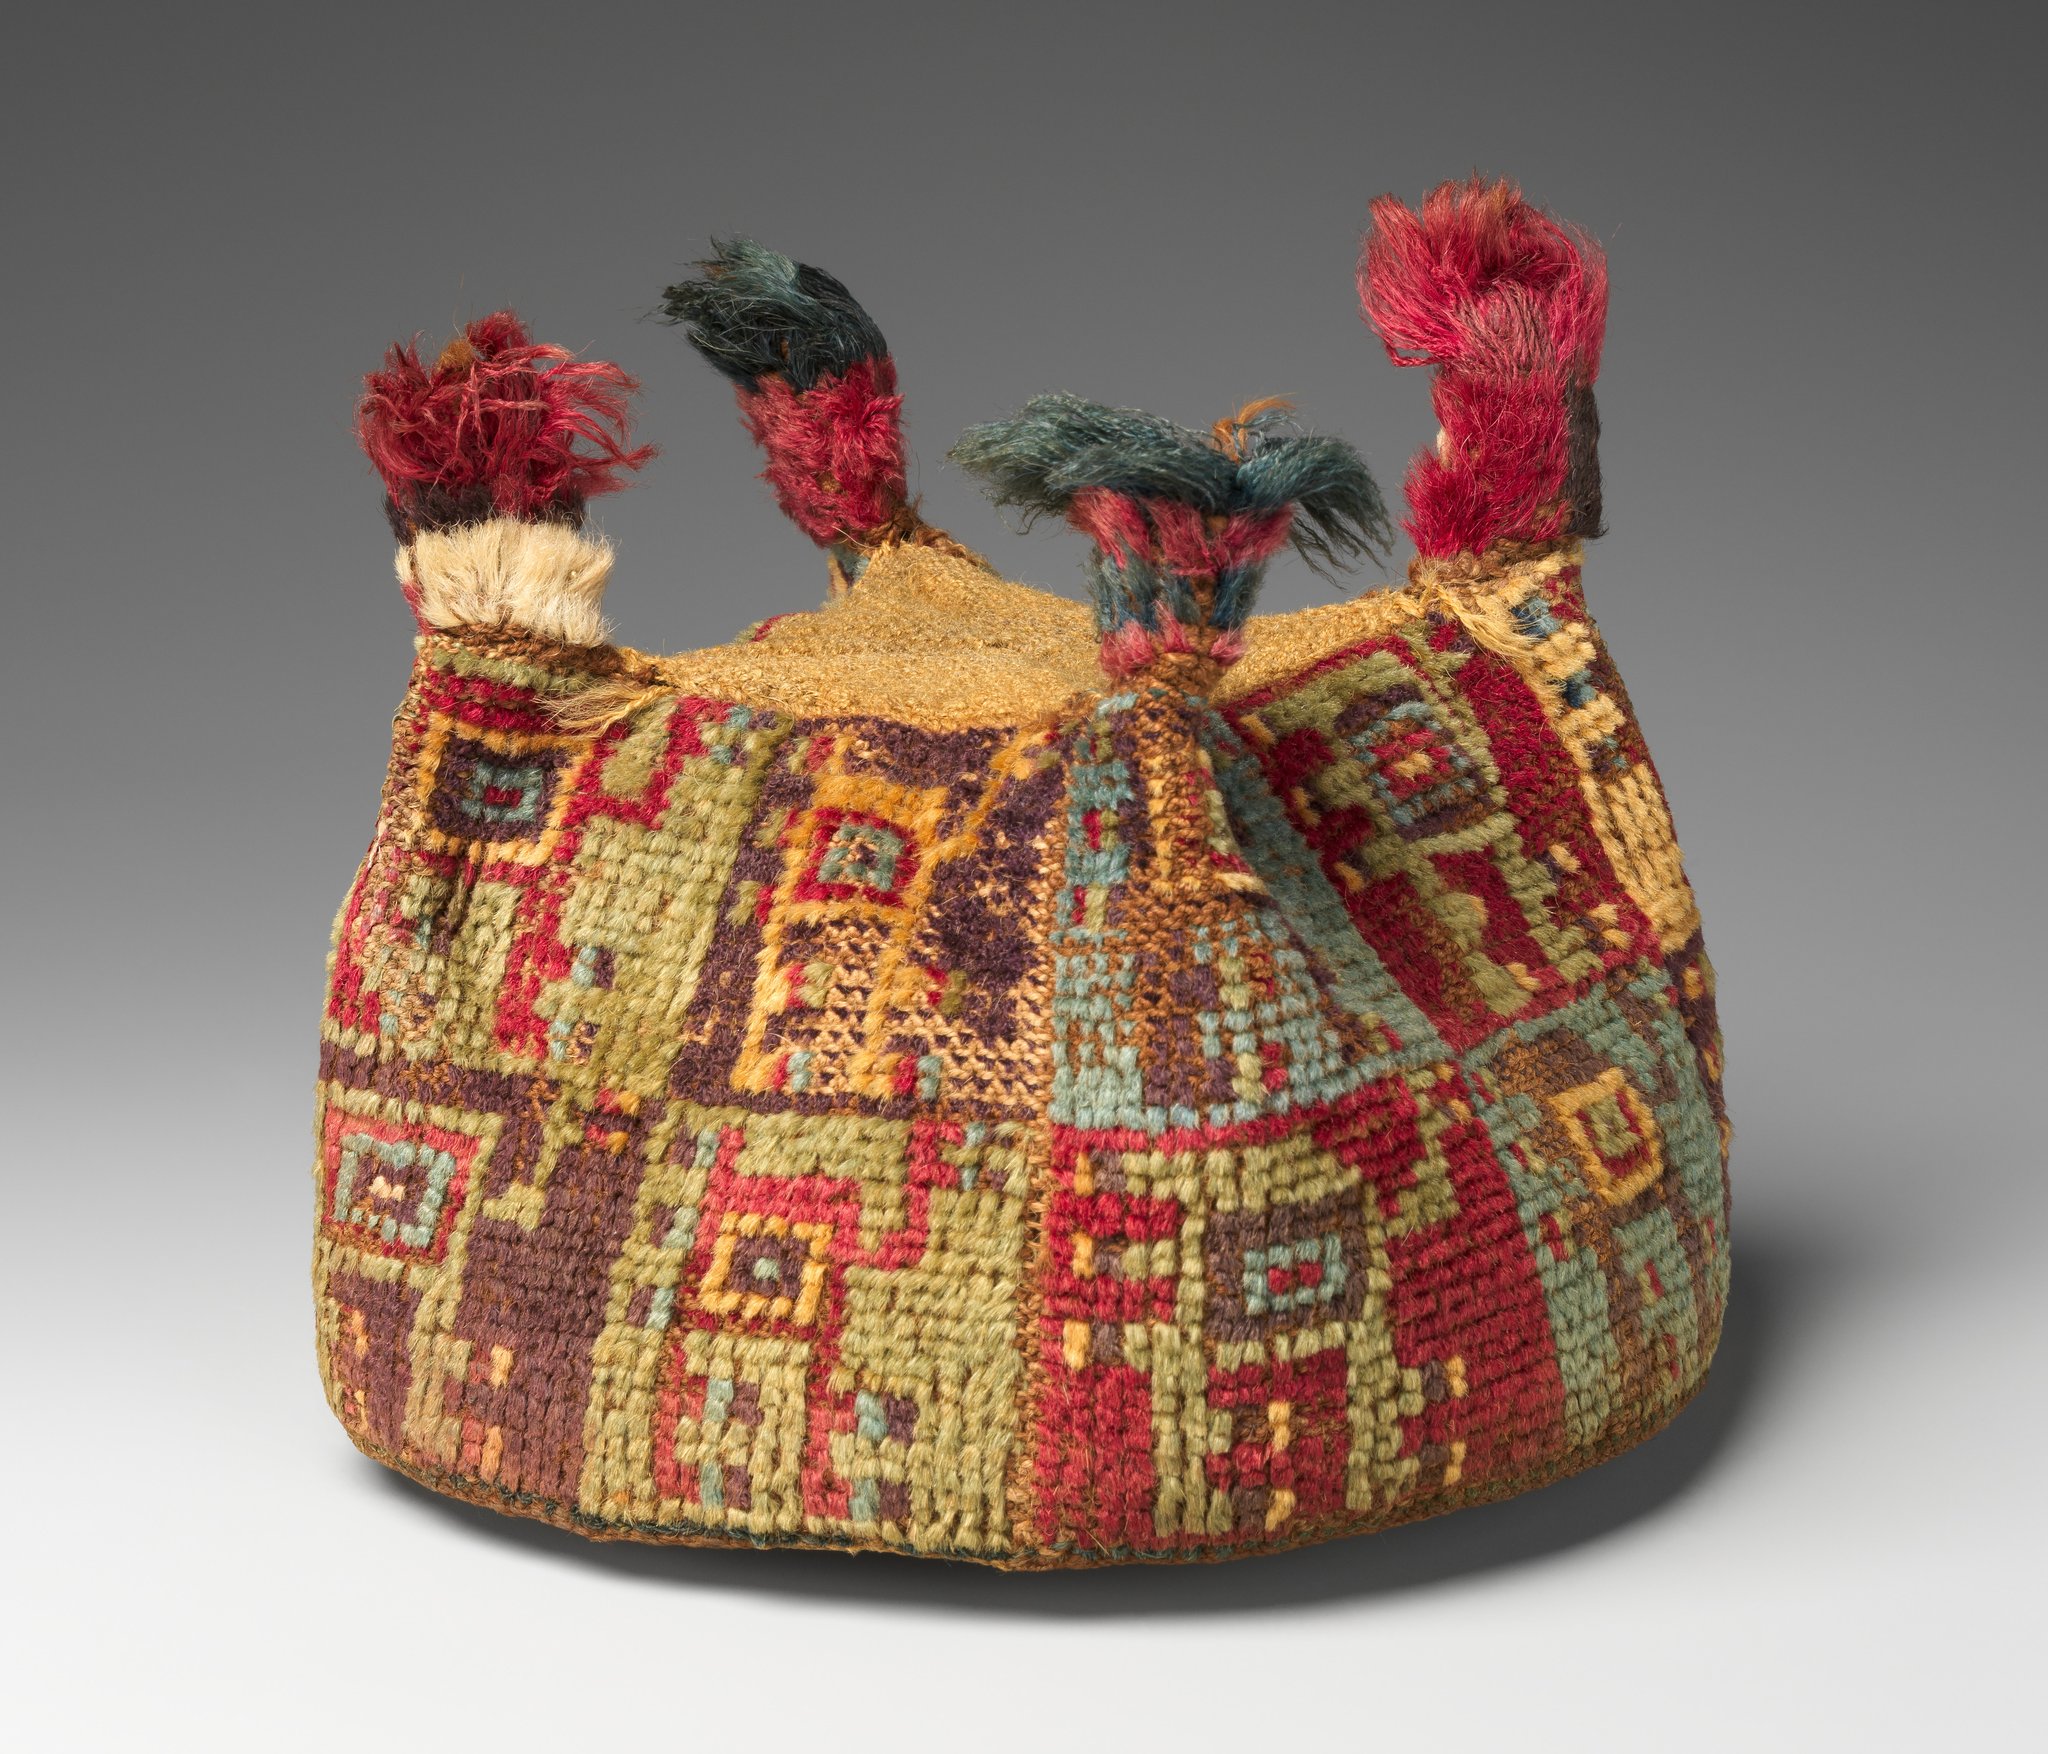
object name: hat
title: Four-Cornered Hat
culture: wari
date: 601-900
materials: animal fiber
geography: peru